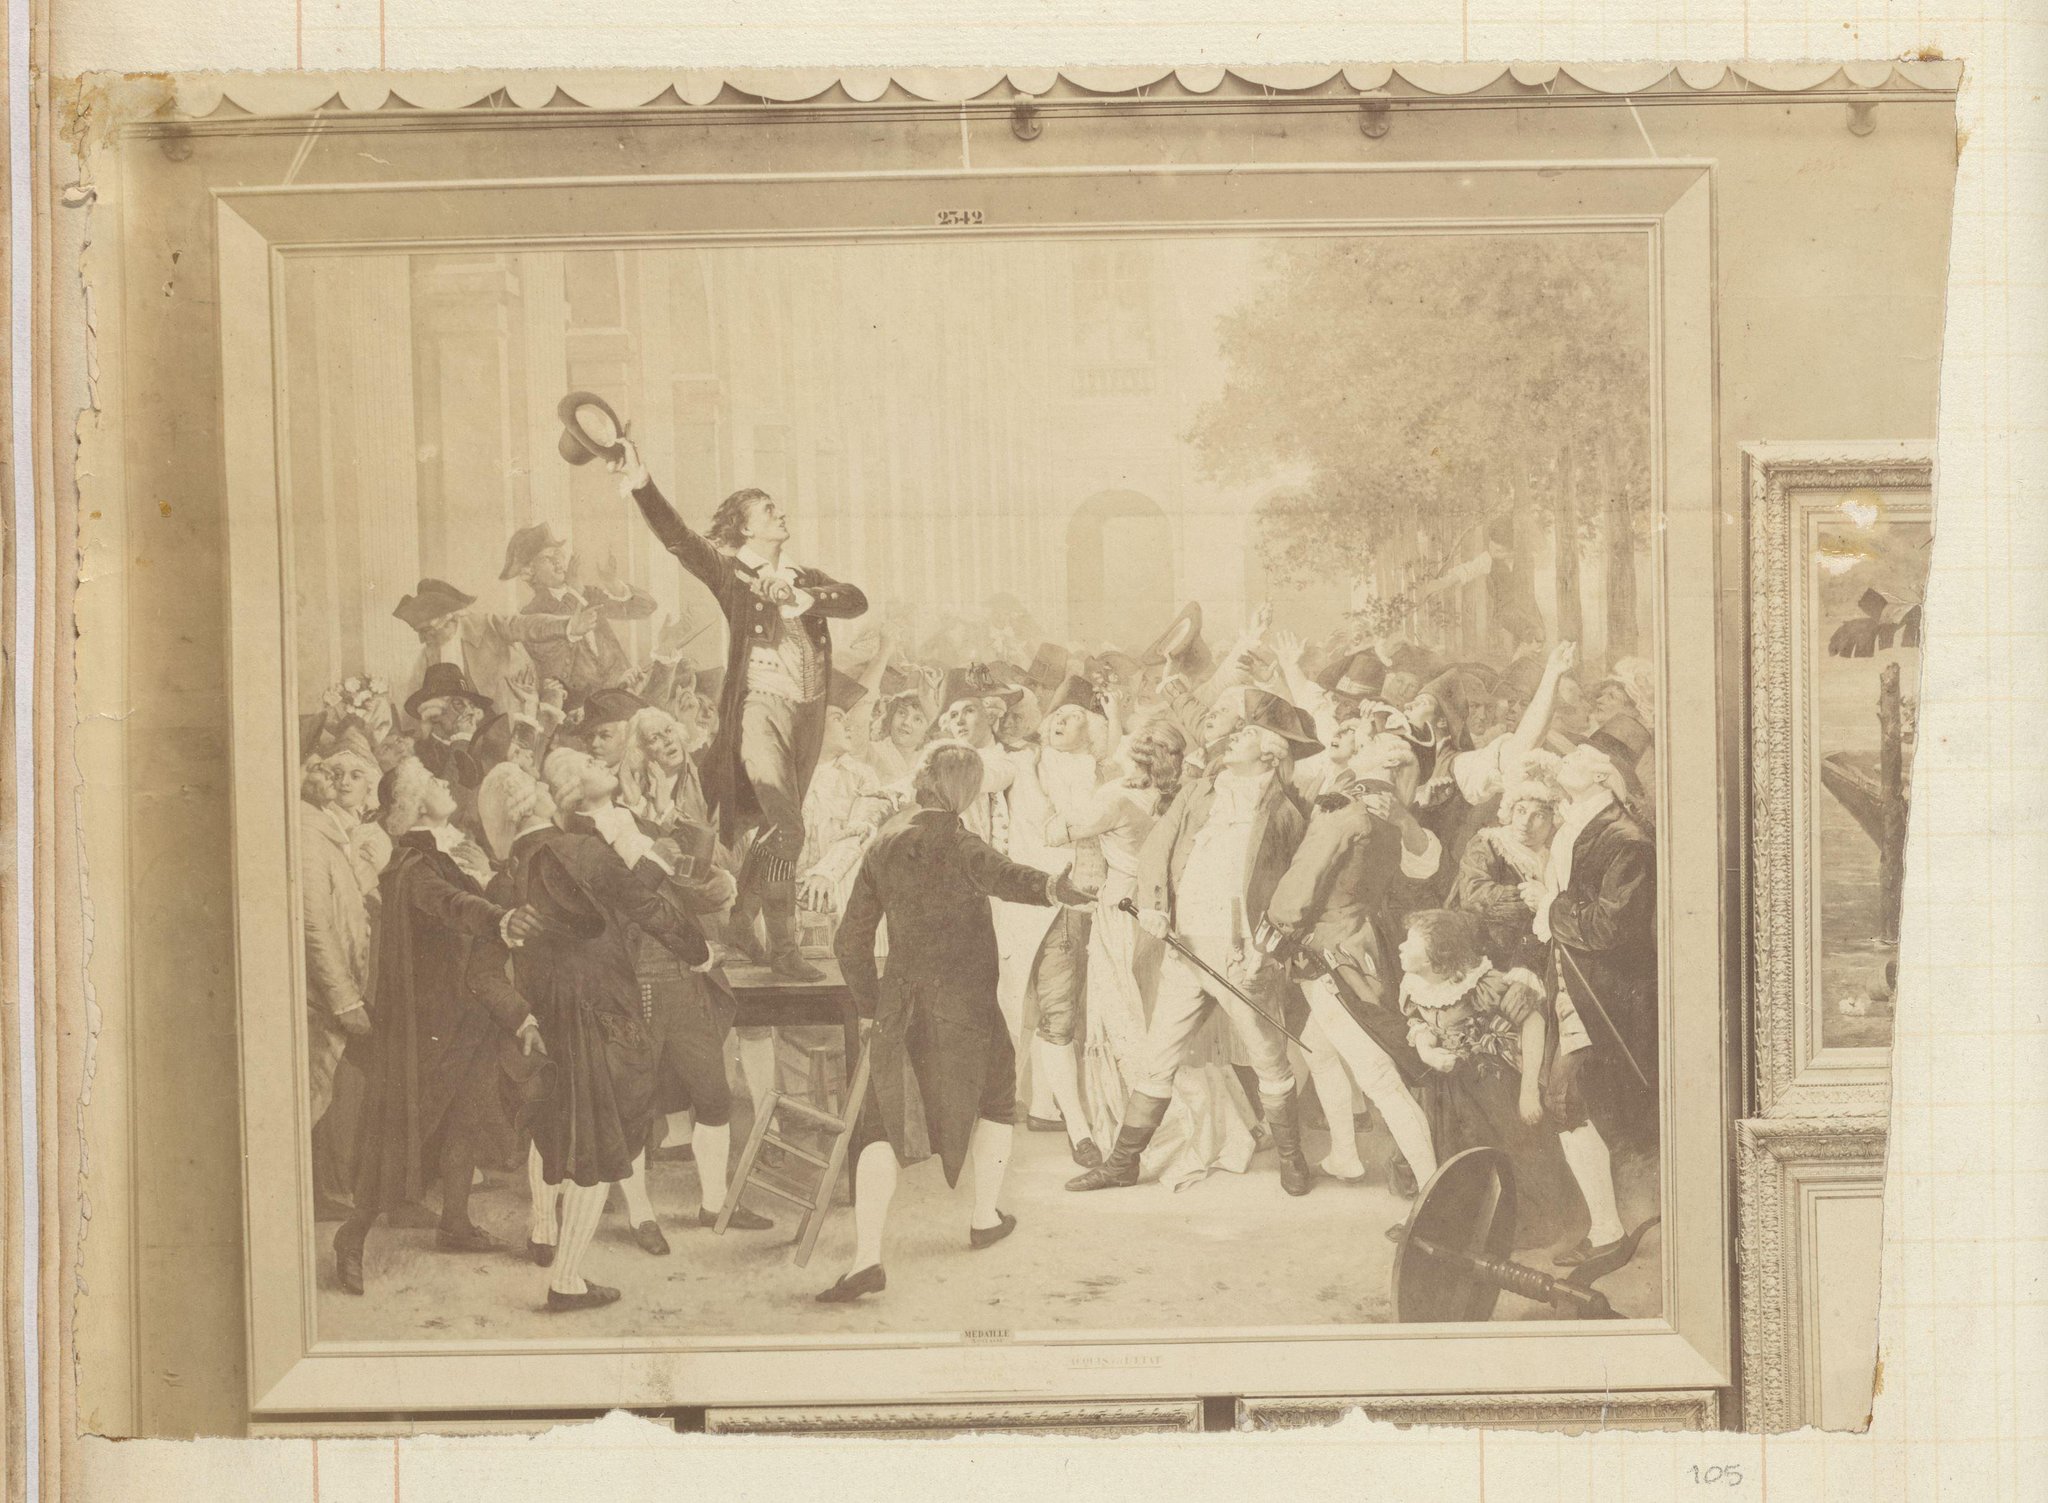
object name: photograph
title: Wand met een schilderij met opschrift 'Médaille 3e classe', voorstellend een orerende man op een plein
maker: Anonymous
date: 1880-1900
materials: paper, photographic support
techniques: albumen print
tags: picture, painting, person addressing a group, orator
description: Foto is deels afgescheurd, rechts zijn nog twee delen van schilderijen zichtbaar. Onderdeel van Frans kunstenaarsalbum.